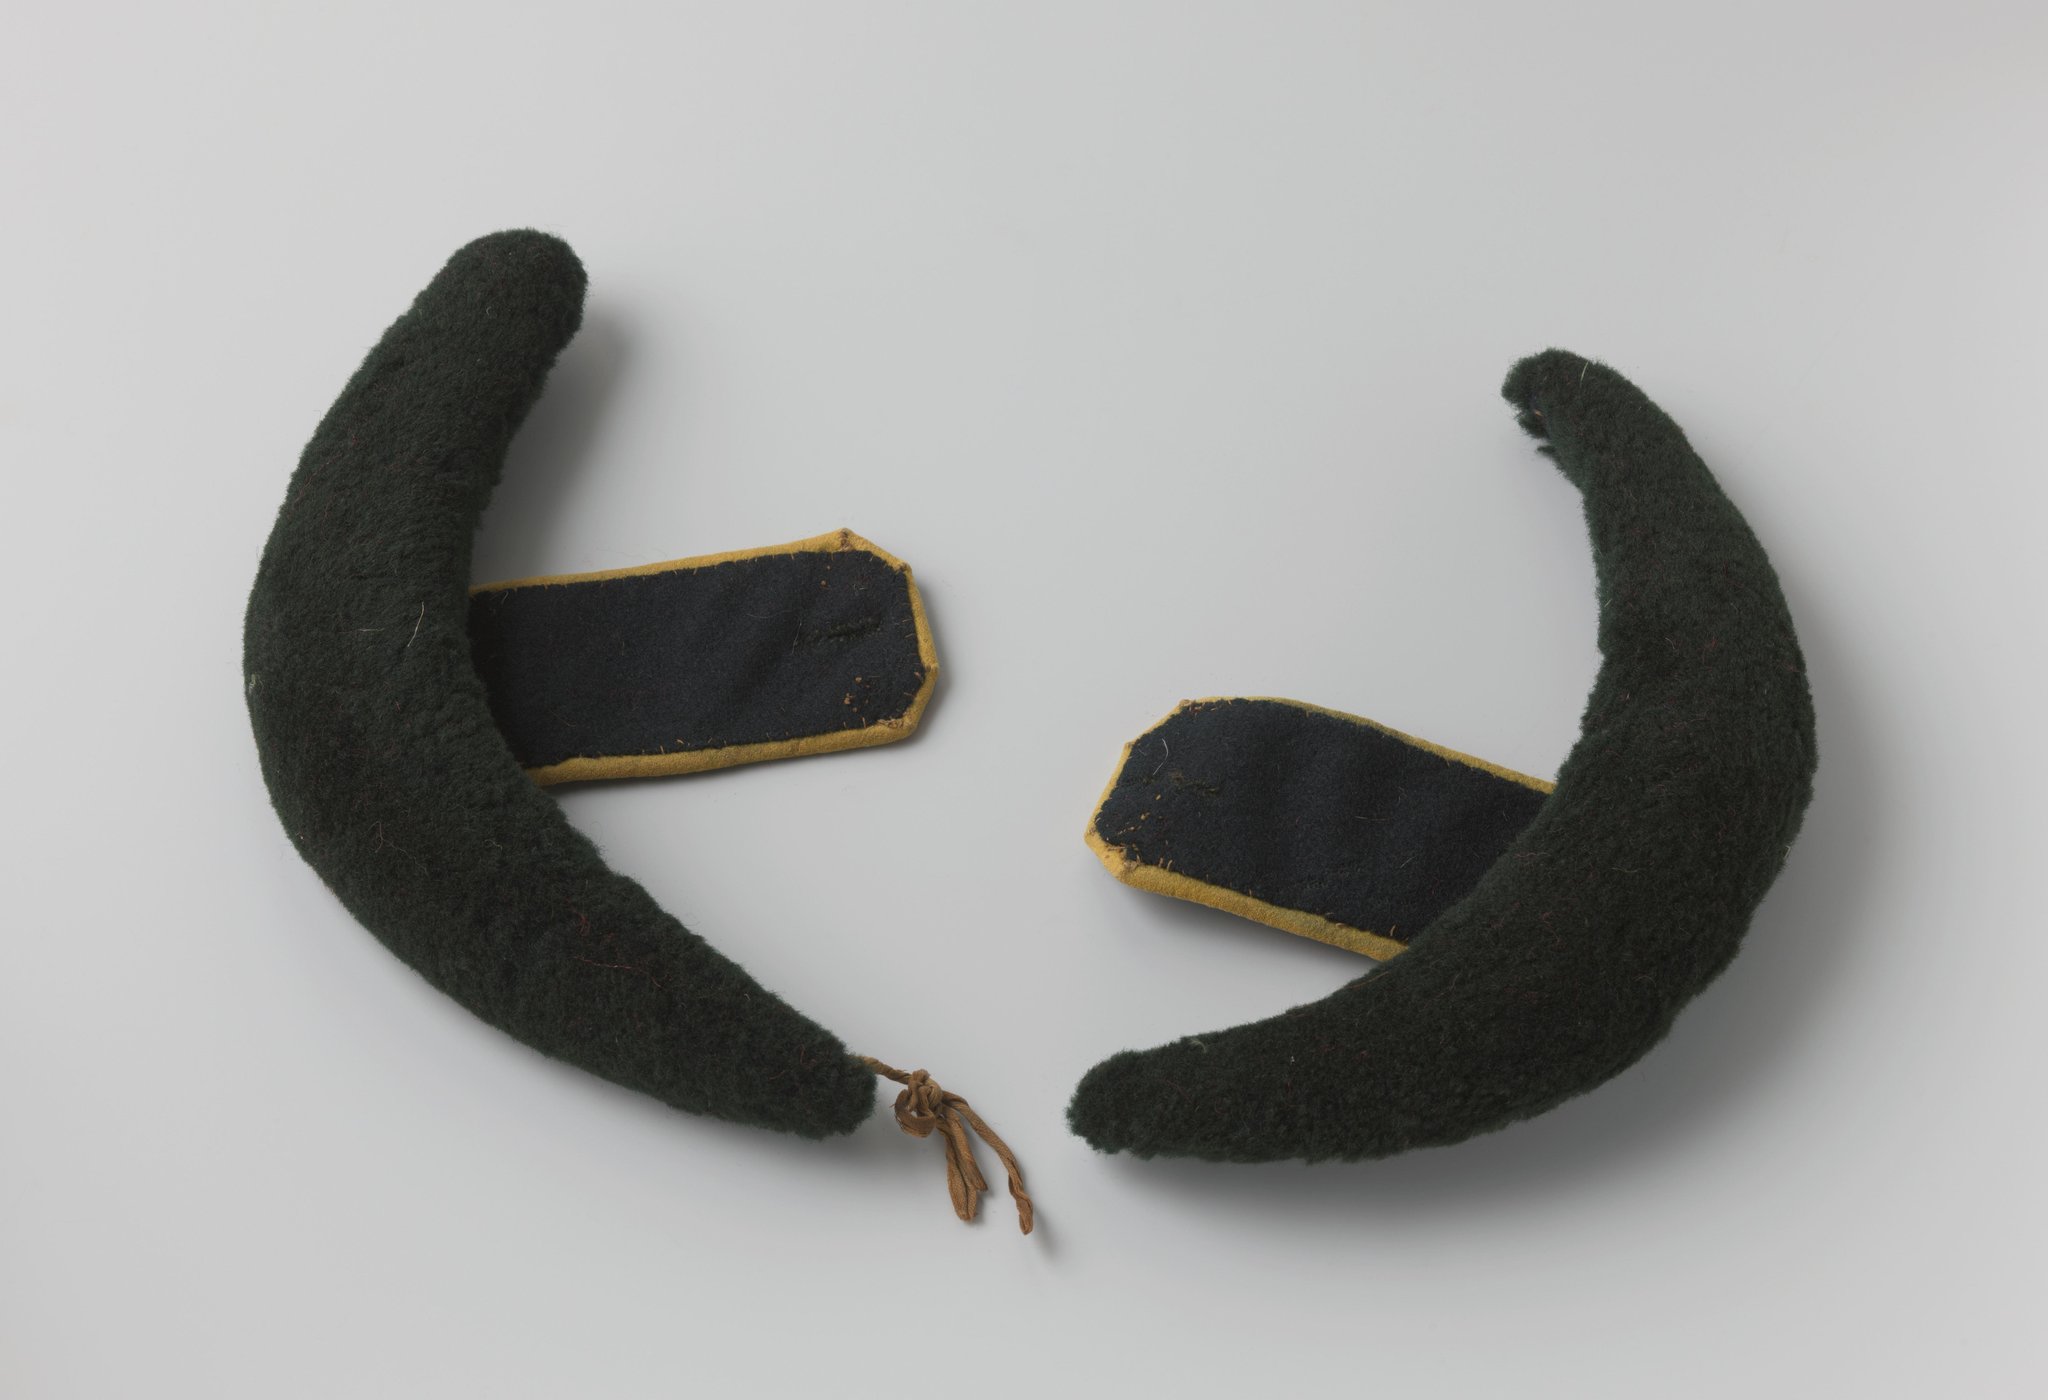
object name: shoulder loop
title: Wings, halfrond van groene wol gevoerd met groen laken, voor jagers of vrijwillige jagers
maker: Anonymous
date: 1830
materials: textile, wool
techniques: stitching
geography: netherlands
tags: netherlands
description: Halfronde groen wollen schouderbedekking, gevoerd met groen laken. Met groen lakense epaulet, geel gebiesd met knoopsgat. Veters voor bevestiging ontbreken.